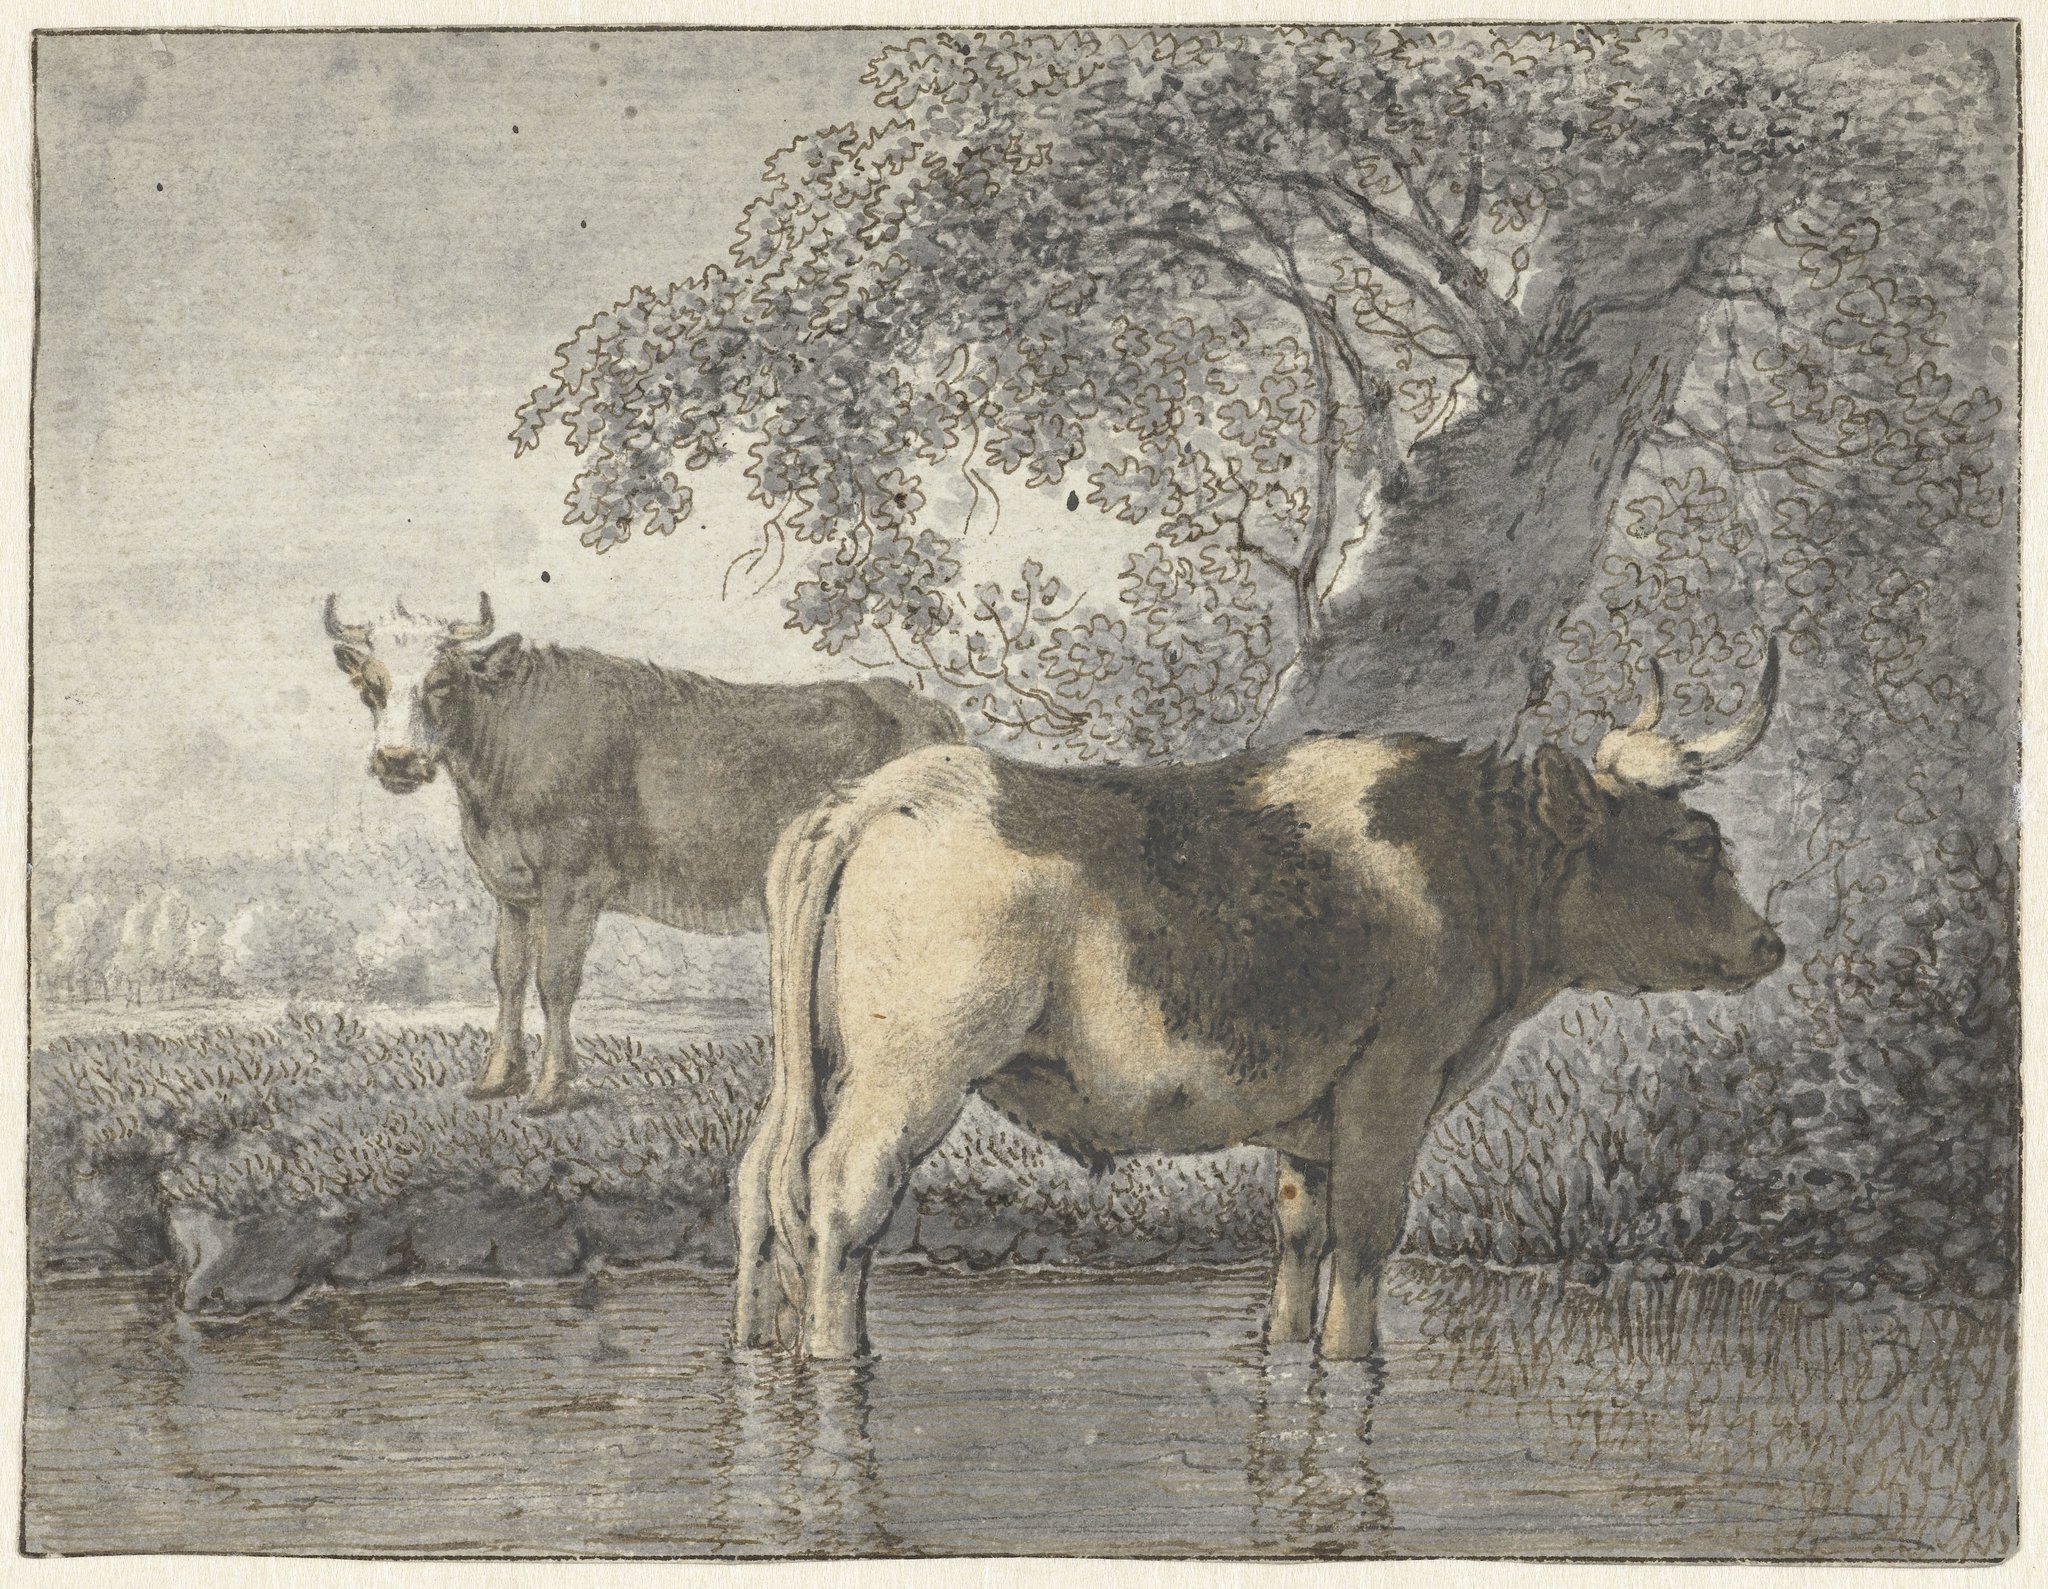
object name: drawing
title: Twee koeien onder een boom aan het water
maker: cornelis van noorde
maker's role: draughtsman, print maker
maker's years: 1731-1795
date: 1741-1795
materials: chalk, ink, paper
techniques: brush, pen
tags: cow